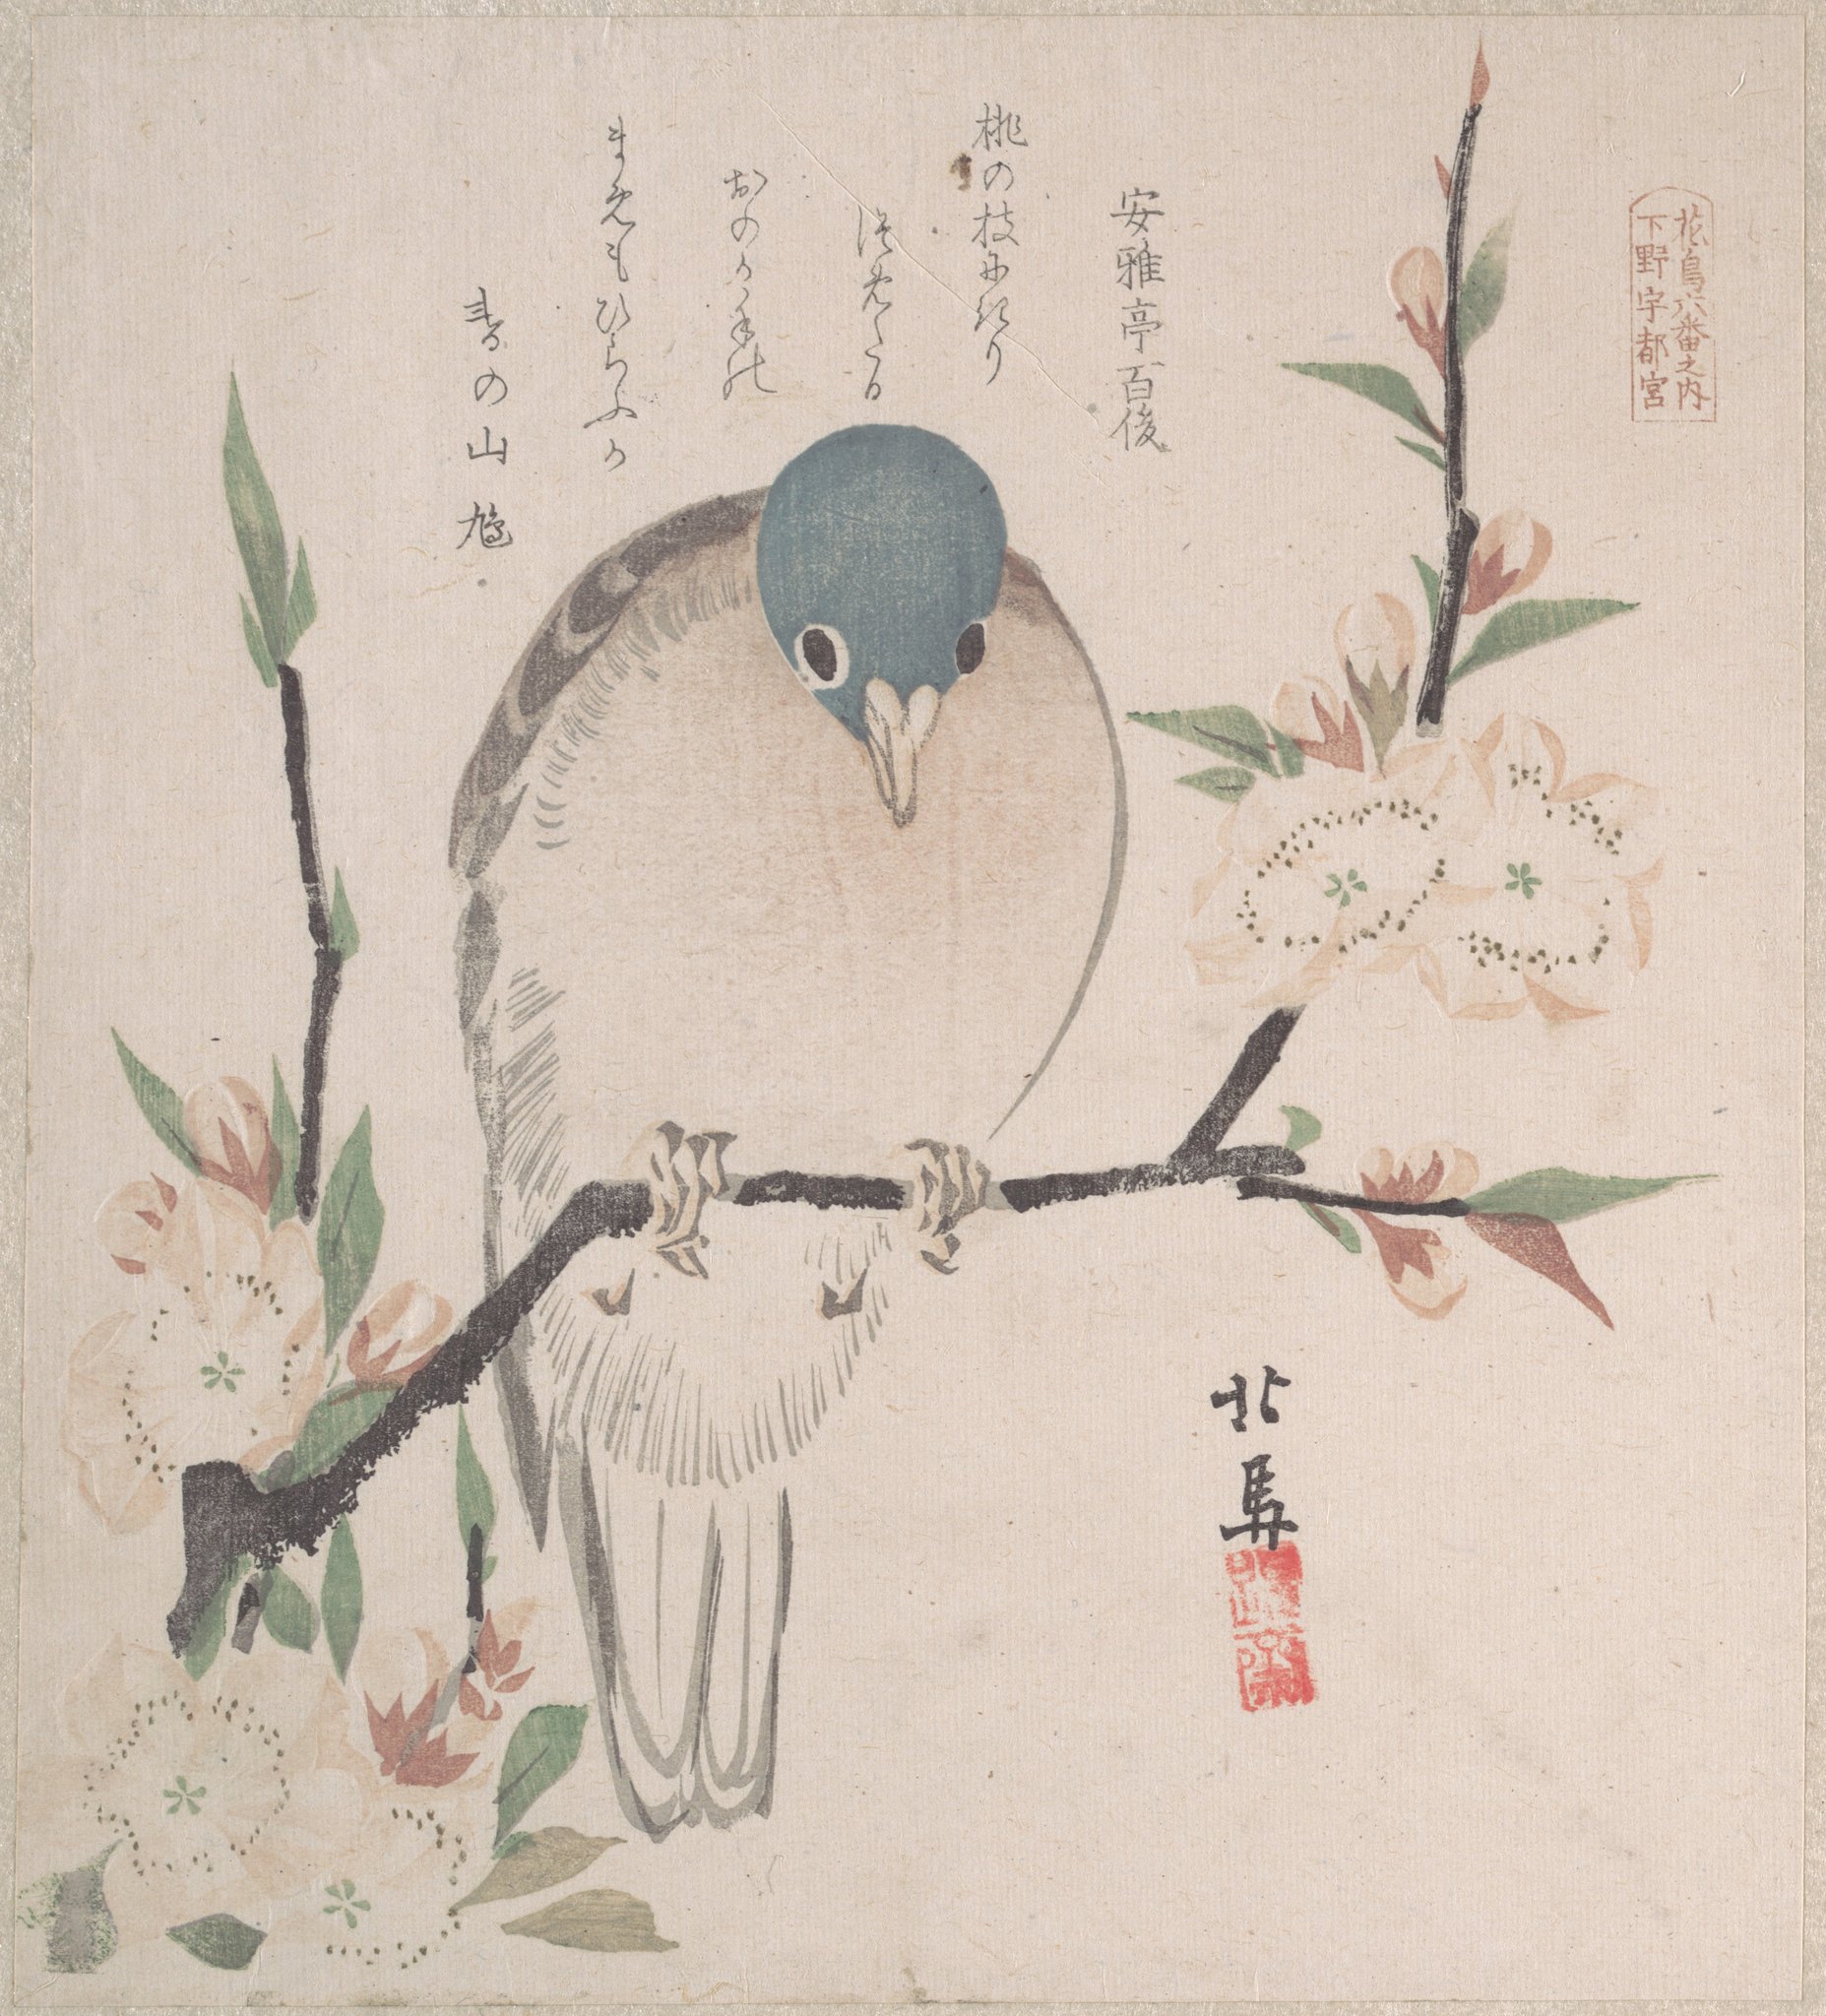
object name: woodblock print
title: Spring Rain Collection (Harusame shū), vol. 3: Mountain Dove and Peach Flowers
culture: japanese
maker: teisai hokuba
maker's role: artist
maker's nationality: japanese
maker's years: 1771-1844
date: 1820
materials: ink, paper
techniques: surimono, woodblock print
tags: doves,japanese,flowers,leaves